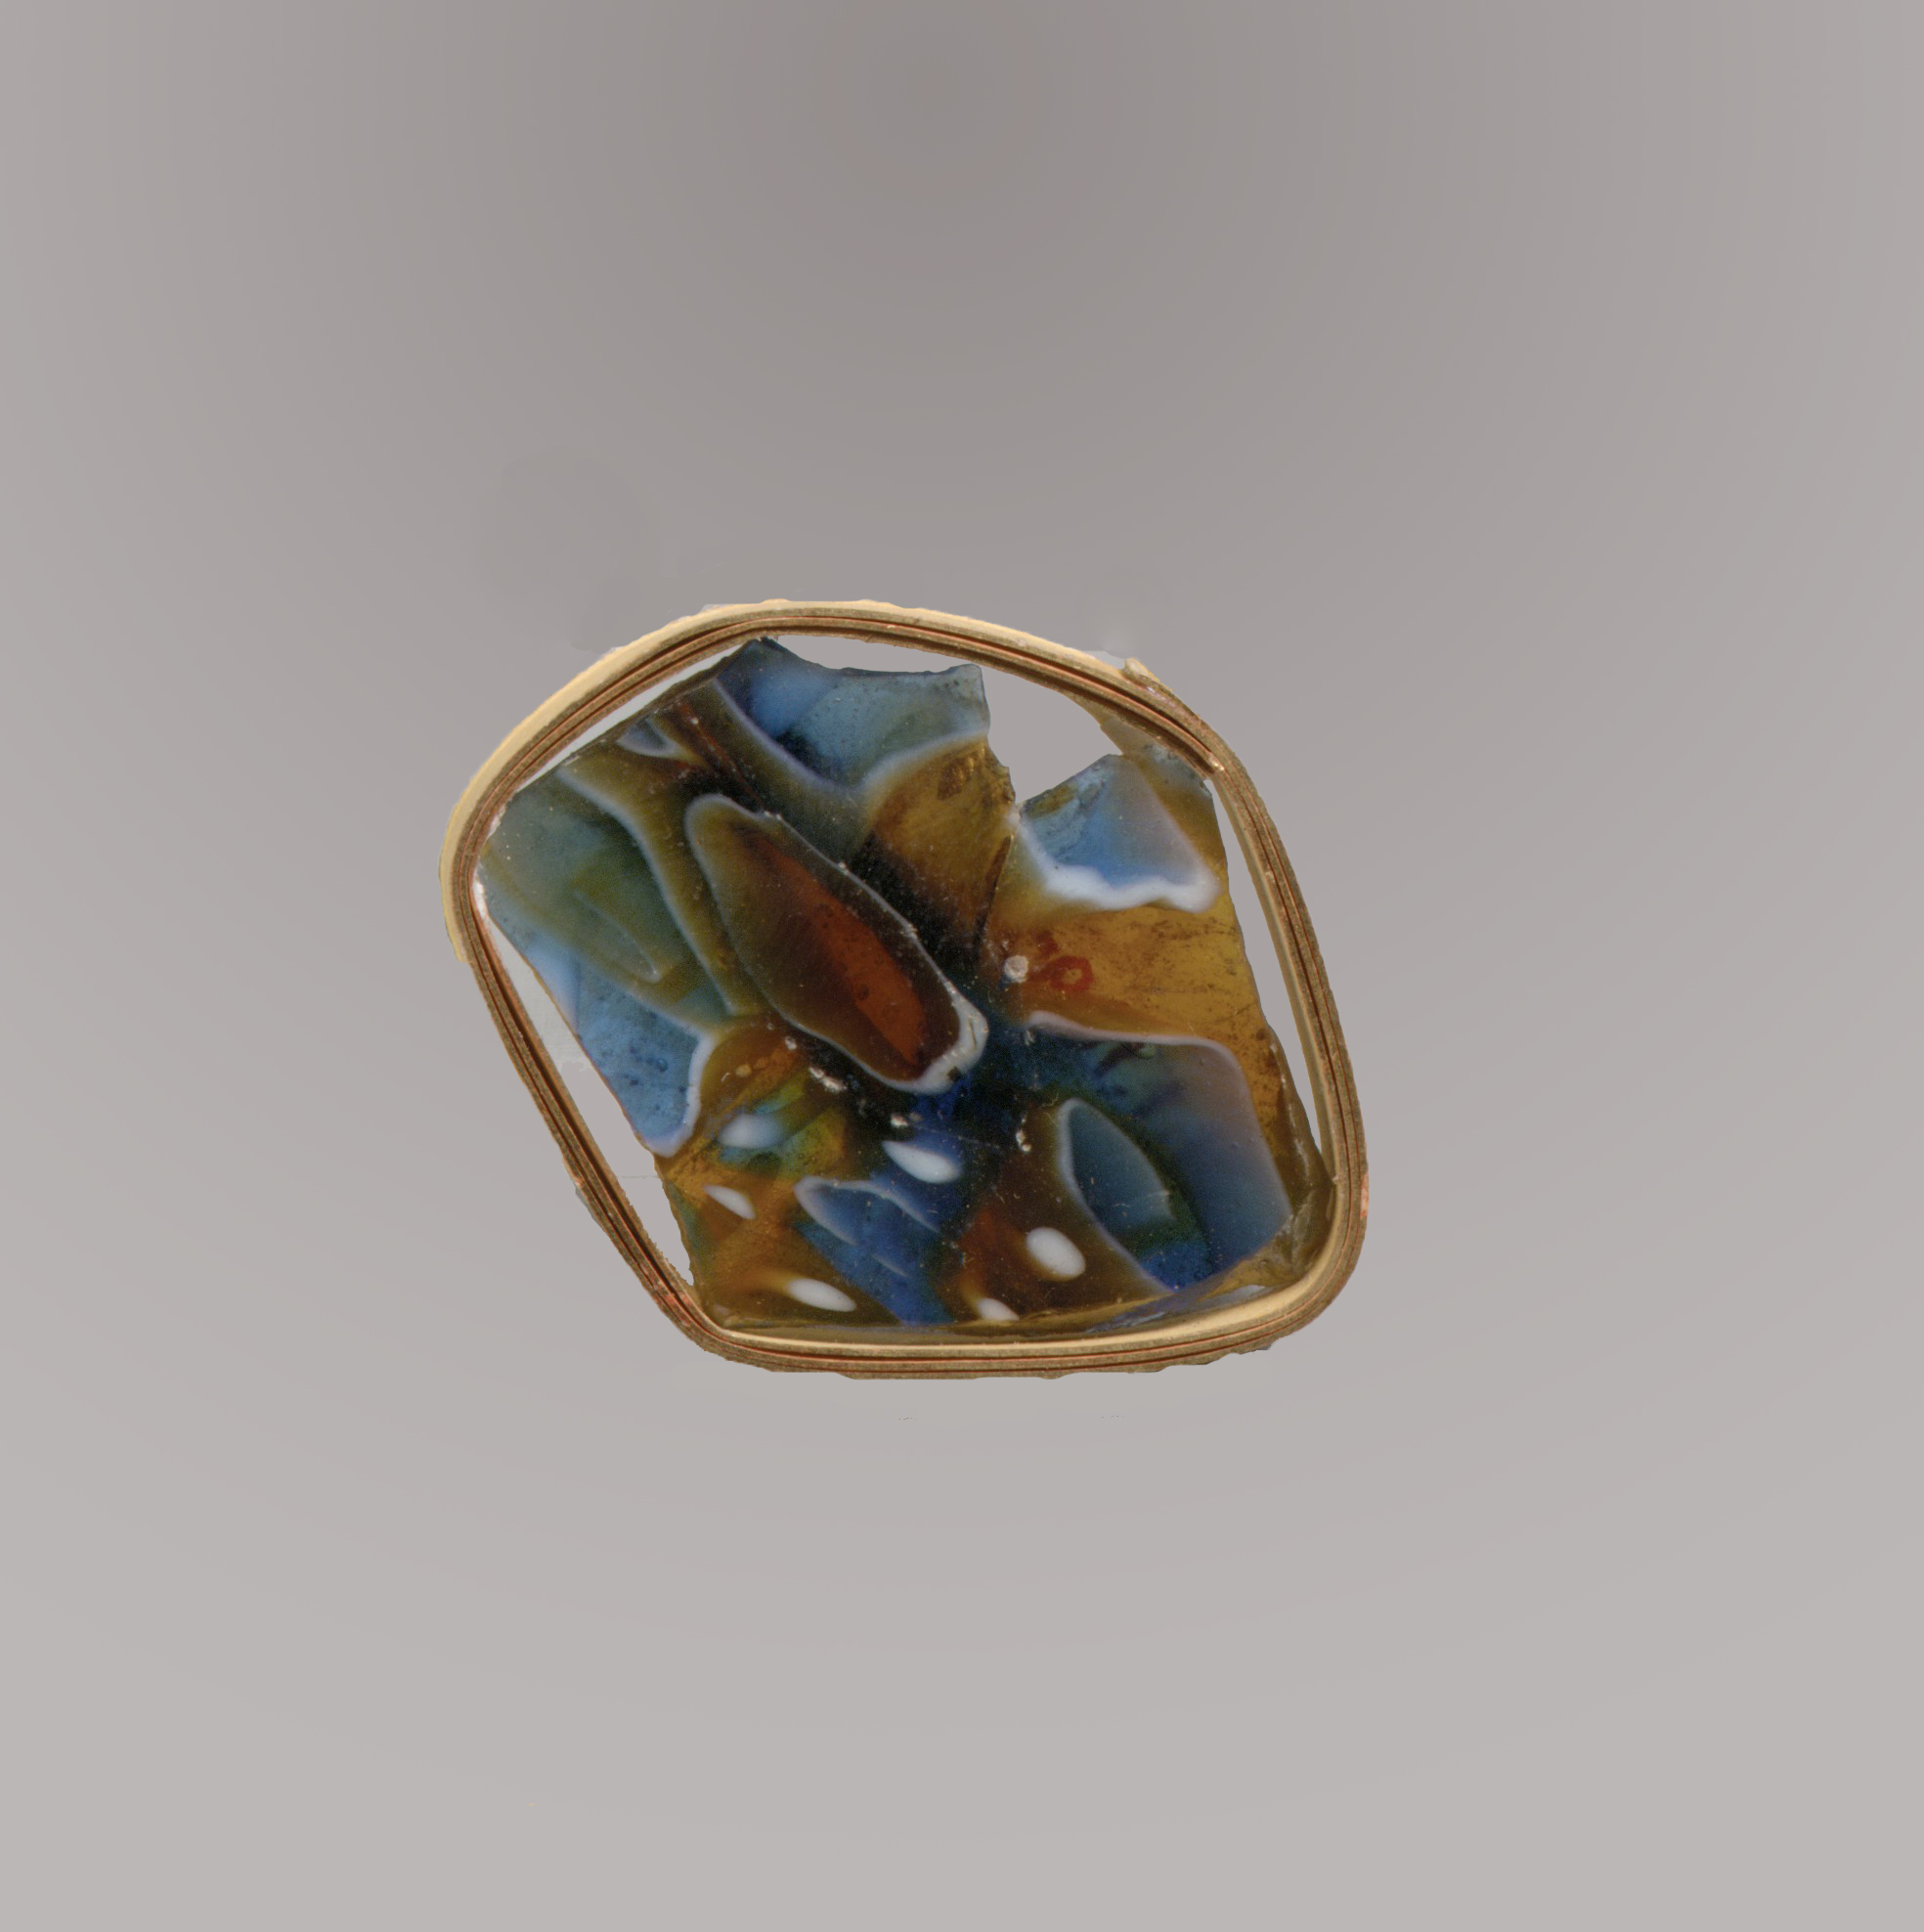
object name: fragment, mosaic bowl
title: Glass mosaic ribbed bowl fragment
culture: roman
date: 34 BCE-33 CE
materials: glass